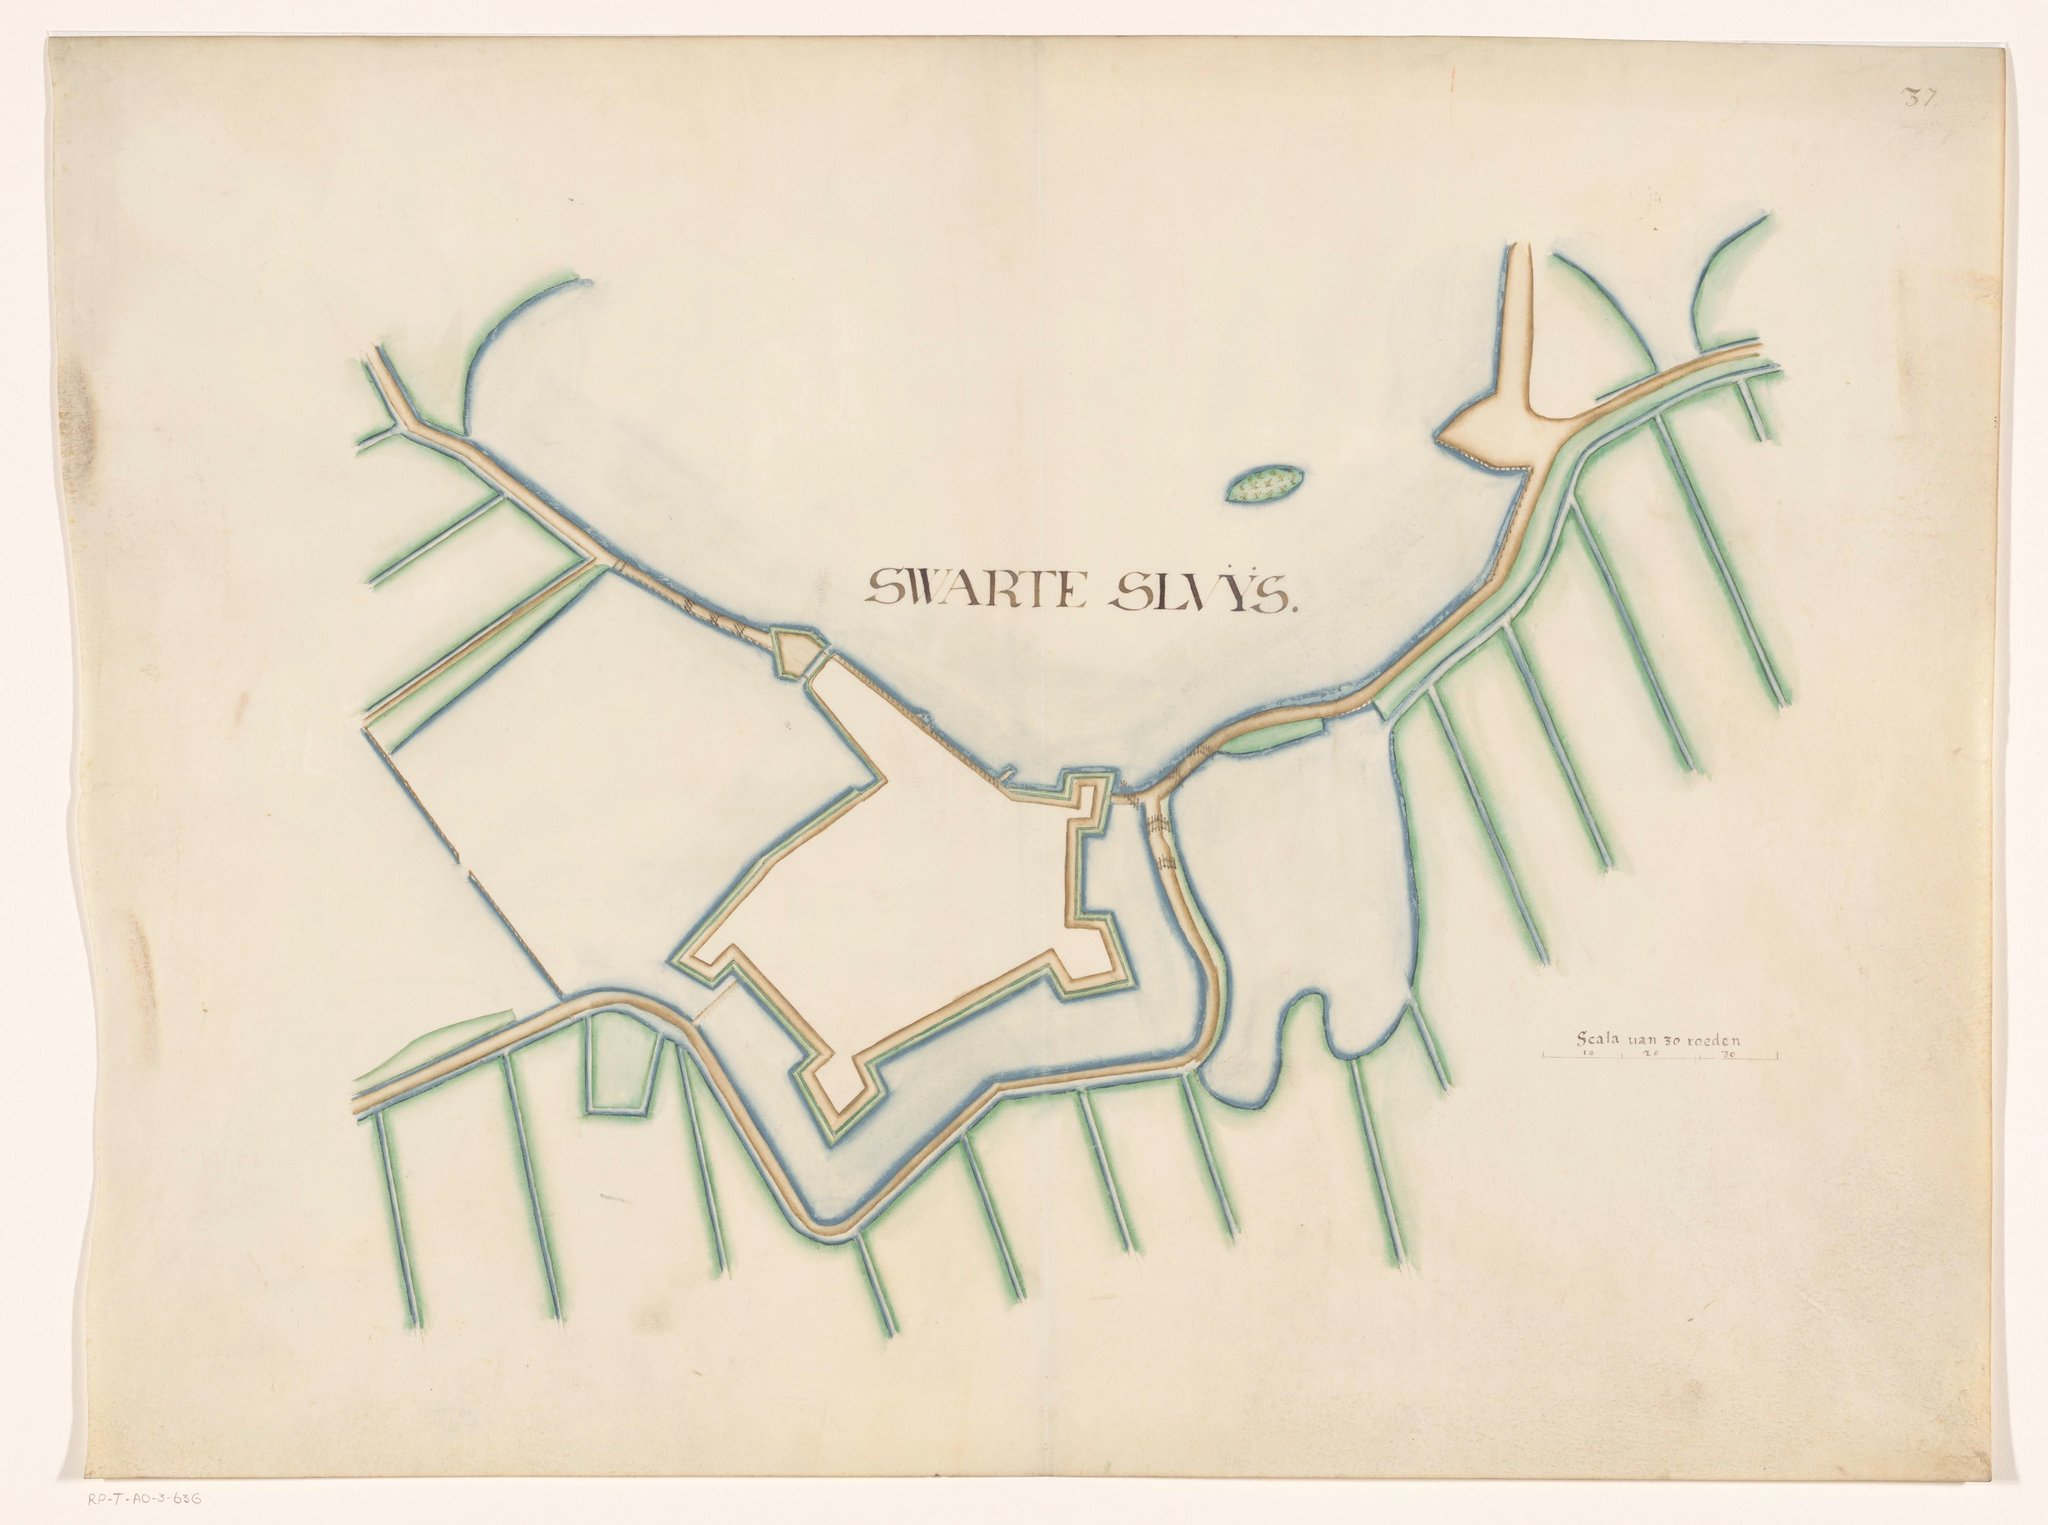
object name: area plan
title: Vestingplattegrond van Zwartsluis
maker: Anonymous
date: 1650-1799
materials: ink, parchment, watercolor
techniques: brush, pen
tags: fortress, maps of cities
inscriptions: collector's mark: Lugt 2228, check stamp: ‘Archief Ministerie van Oorlog Afdeeling Genie’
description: Rechts een schaalstok: Scala van 30 roeden.